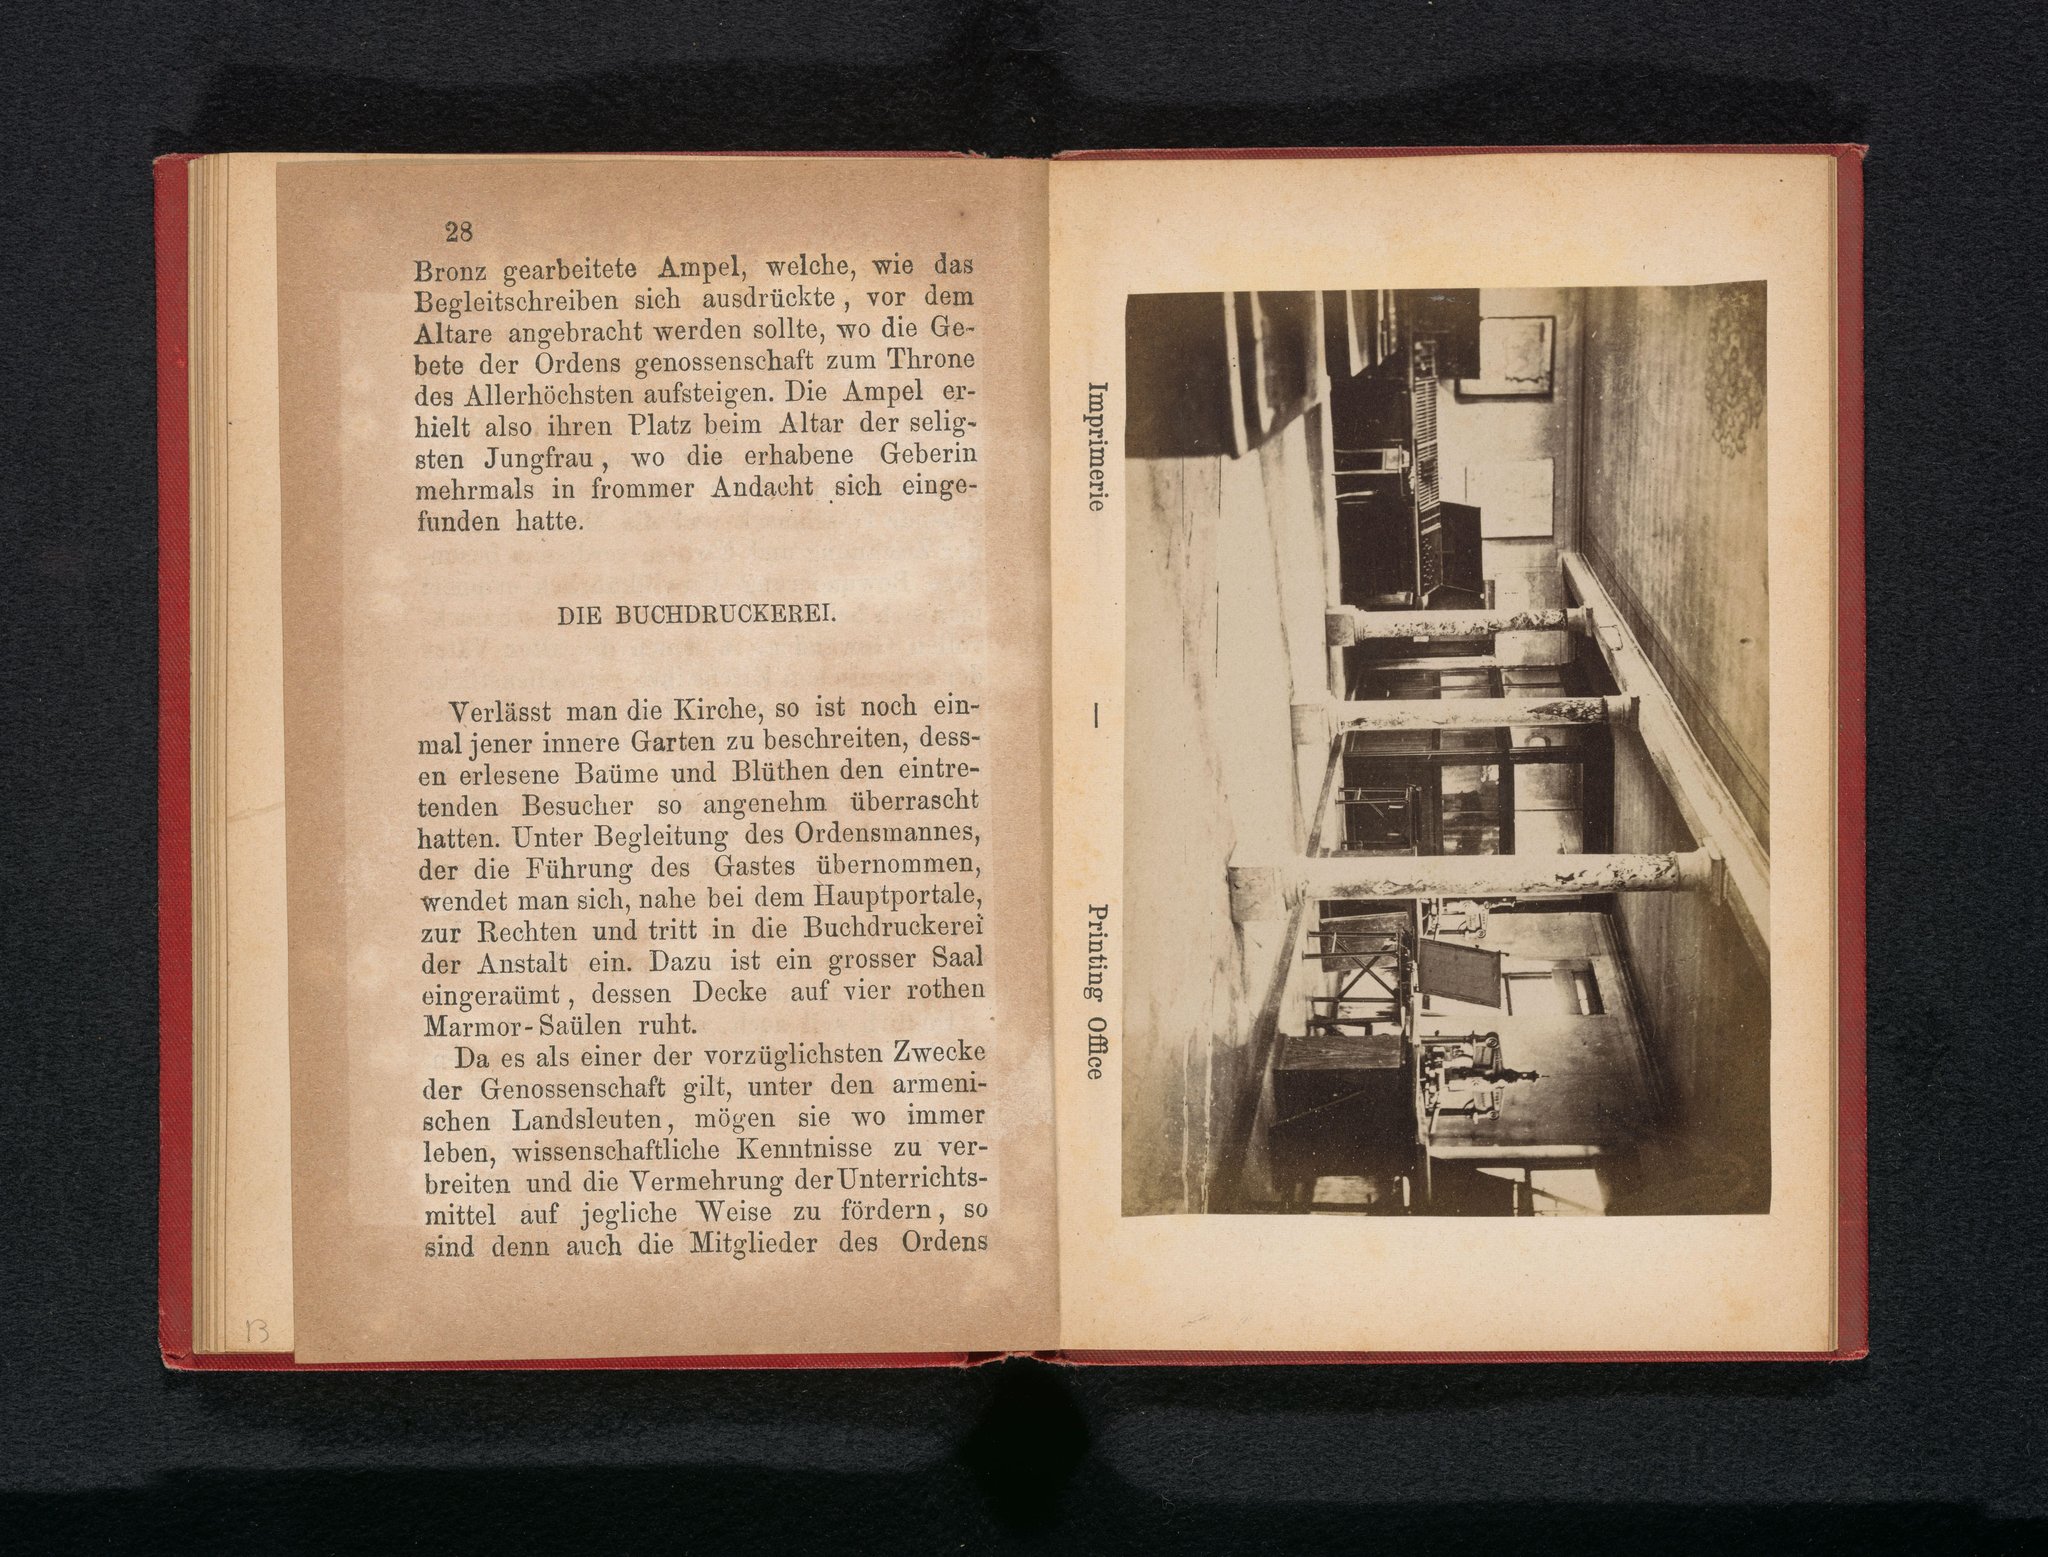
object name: page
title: Printing office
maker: Anonymous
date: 1870-1880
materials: paper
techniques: albumen print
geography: san lazzaro degli armeni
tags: printing, printing office